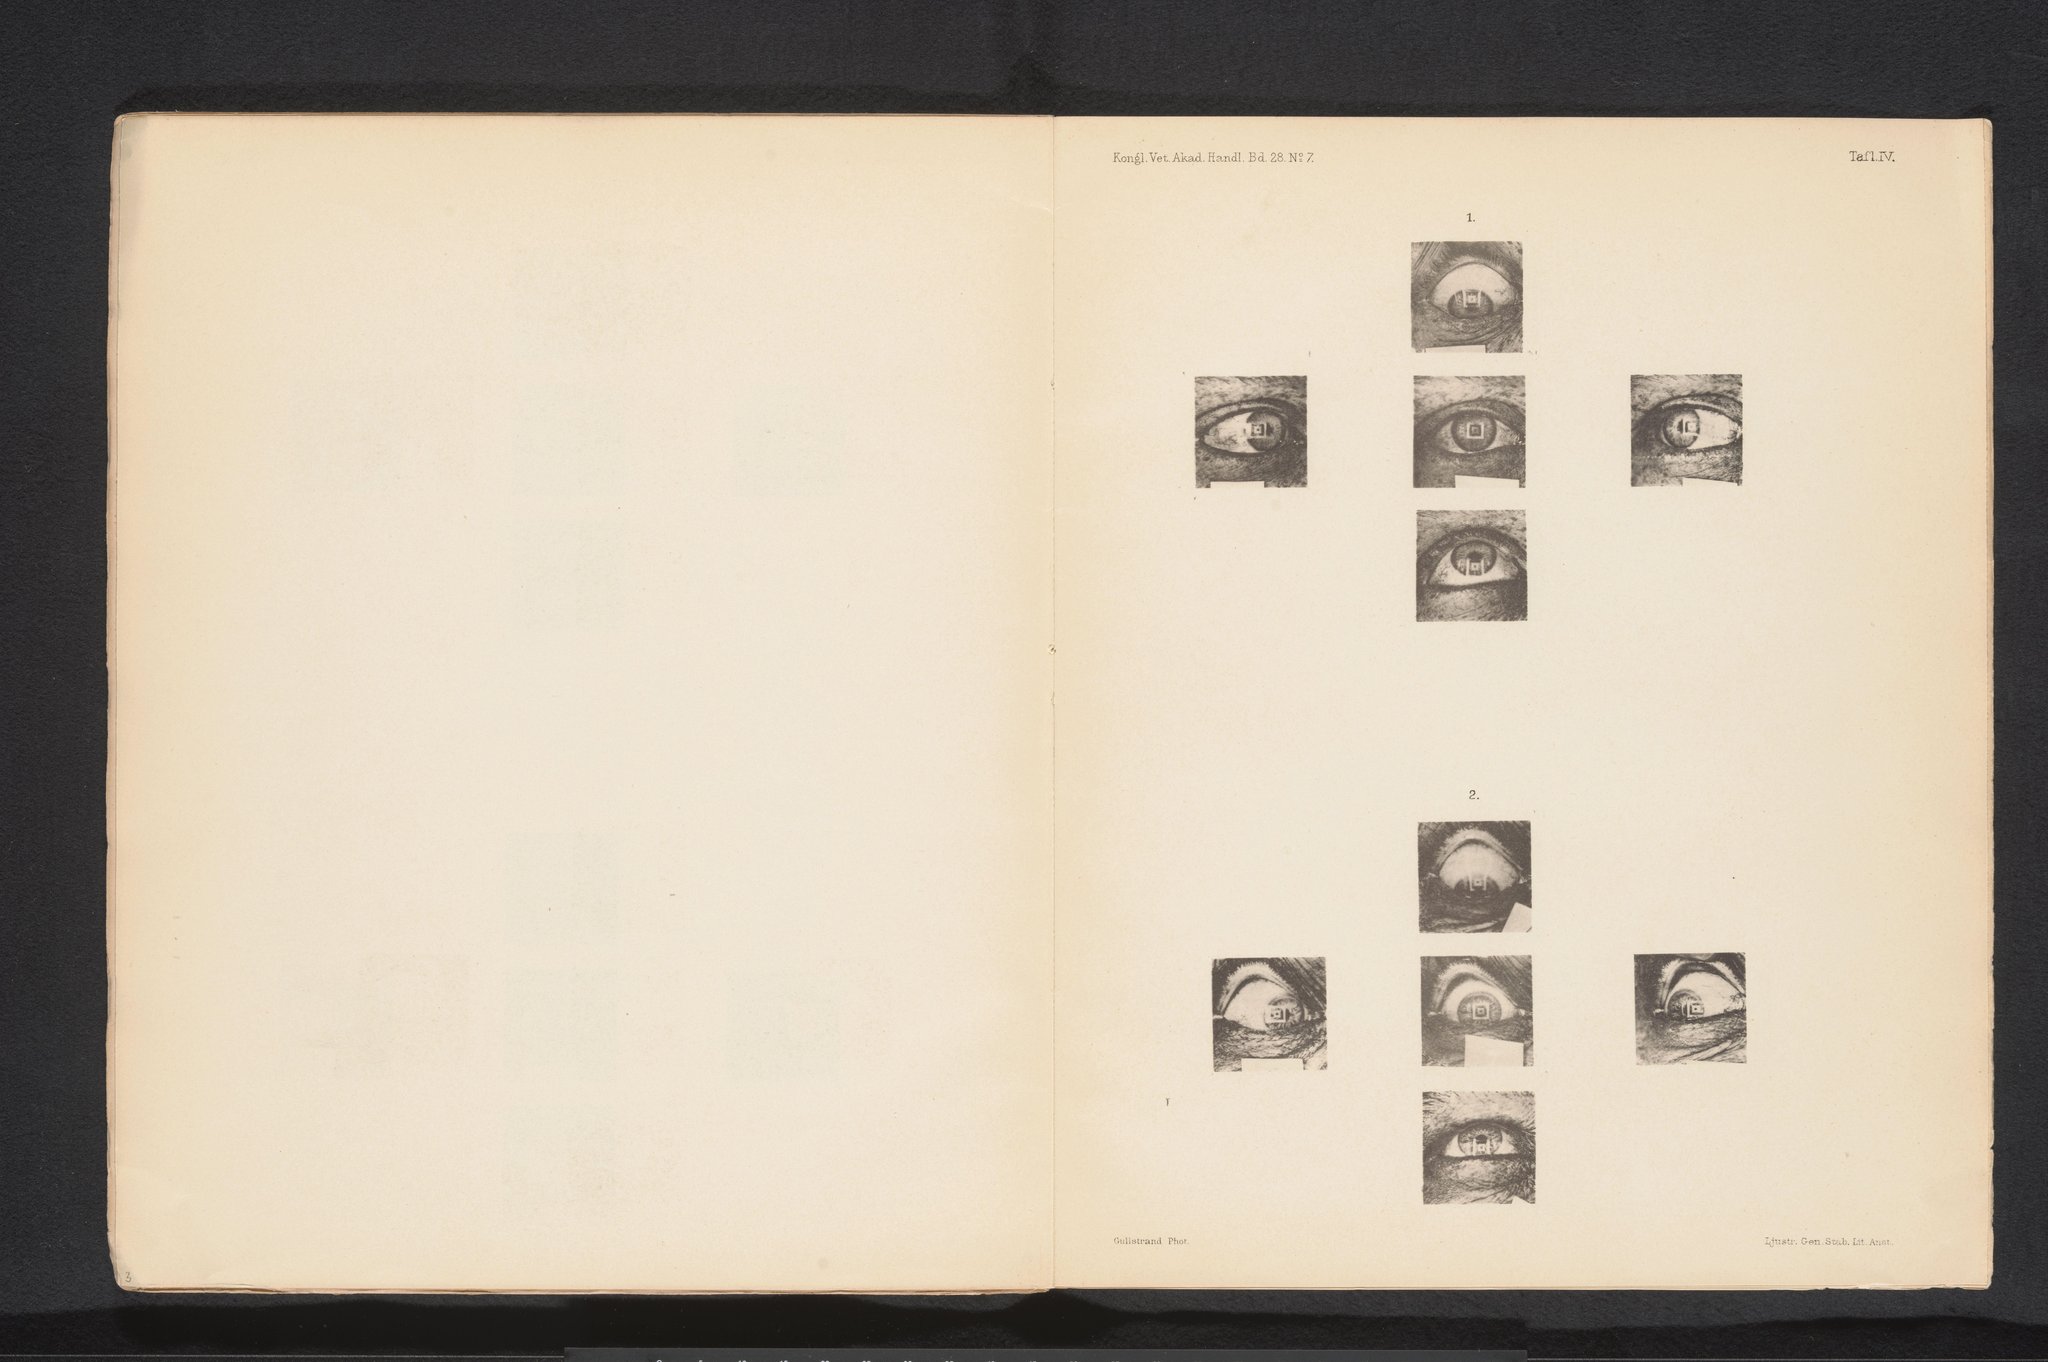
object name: page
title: Tien ogen met daarin vierkanten weerspiegeld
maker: allvar gullstrand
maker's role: arts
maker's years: 1862-1930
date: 1886-1896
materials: paper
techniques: photograph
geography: stockholm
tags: eyes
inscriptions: inscription: ‘Kongl. Vet. Akad. Handl. Bd. 28. No. 7.’, number: ‘Tafl. IV. 1 2’